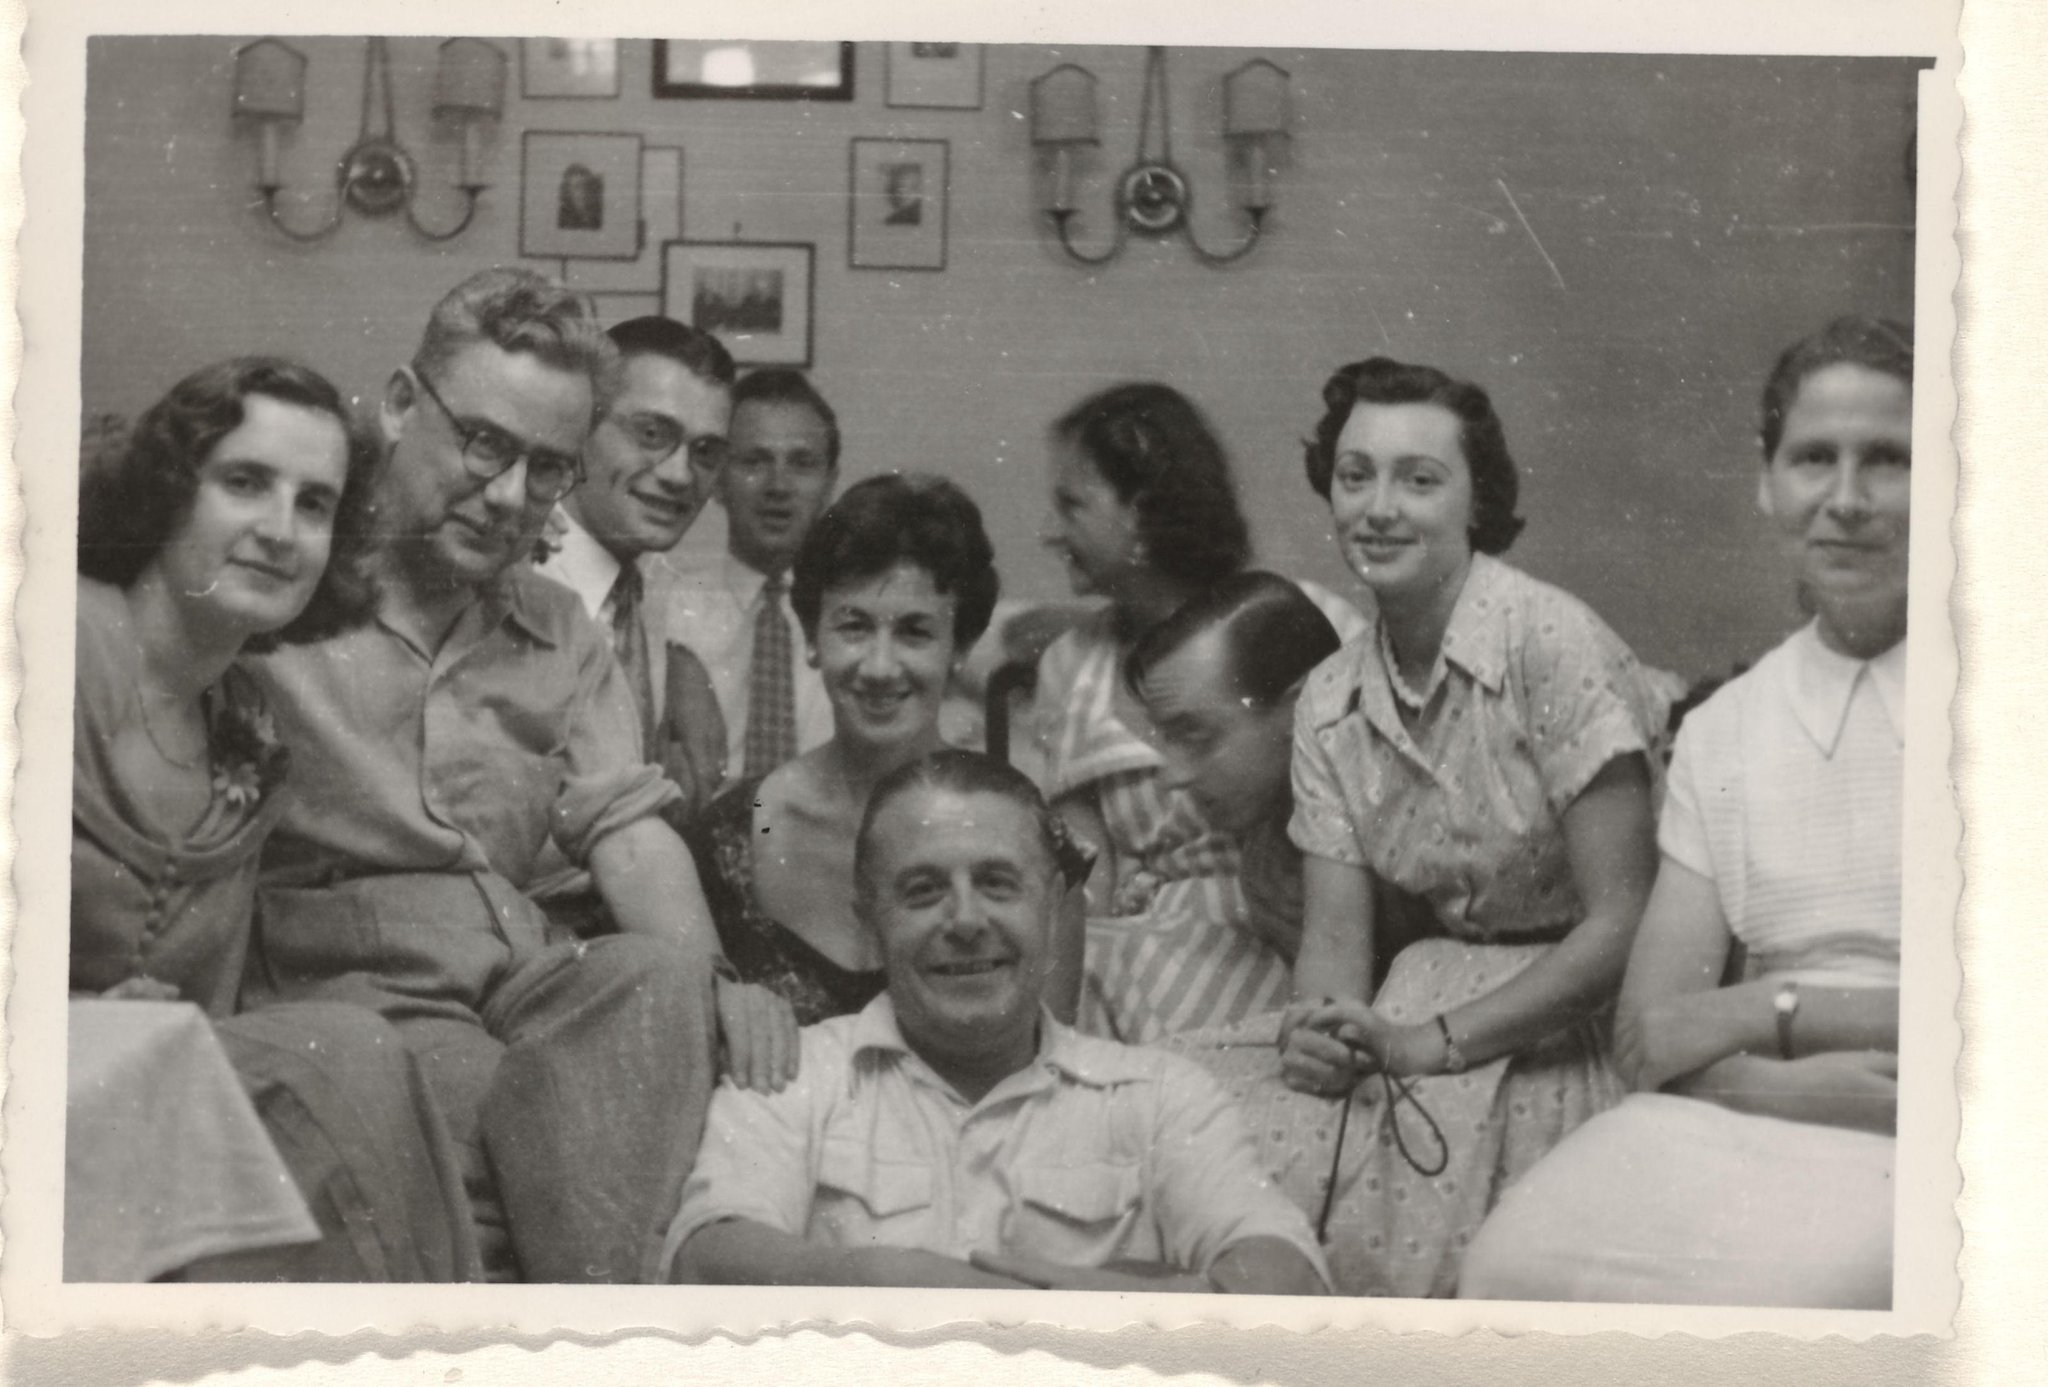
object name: photograph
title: Isabel Wachenheimer met onbekende mensen tijdens een banket voor de armen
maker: Anonymous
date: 1946-1963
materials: photographic support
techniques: gelatin silver print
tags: leiden, isabel wachenheimer-elon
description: Isabel Wachenheimer (1e van links) met onbekende mensen tijdens een banket.